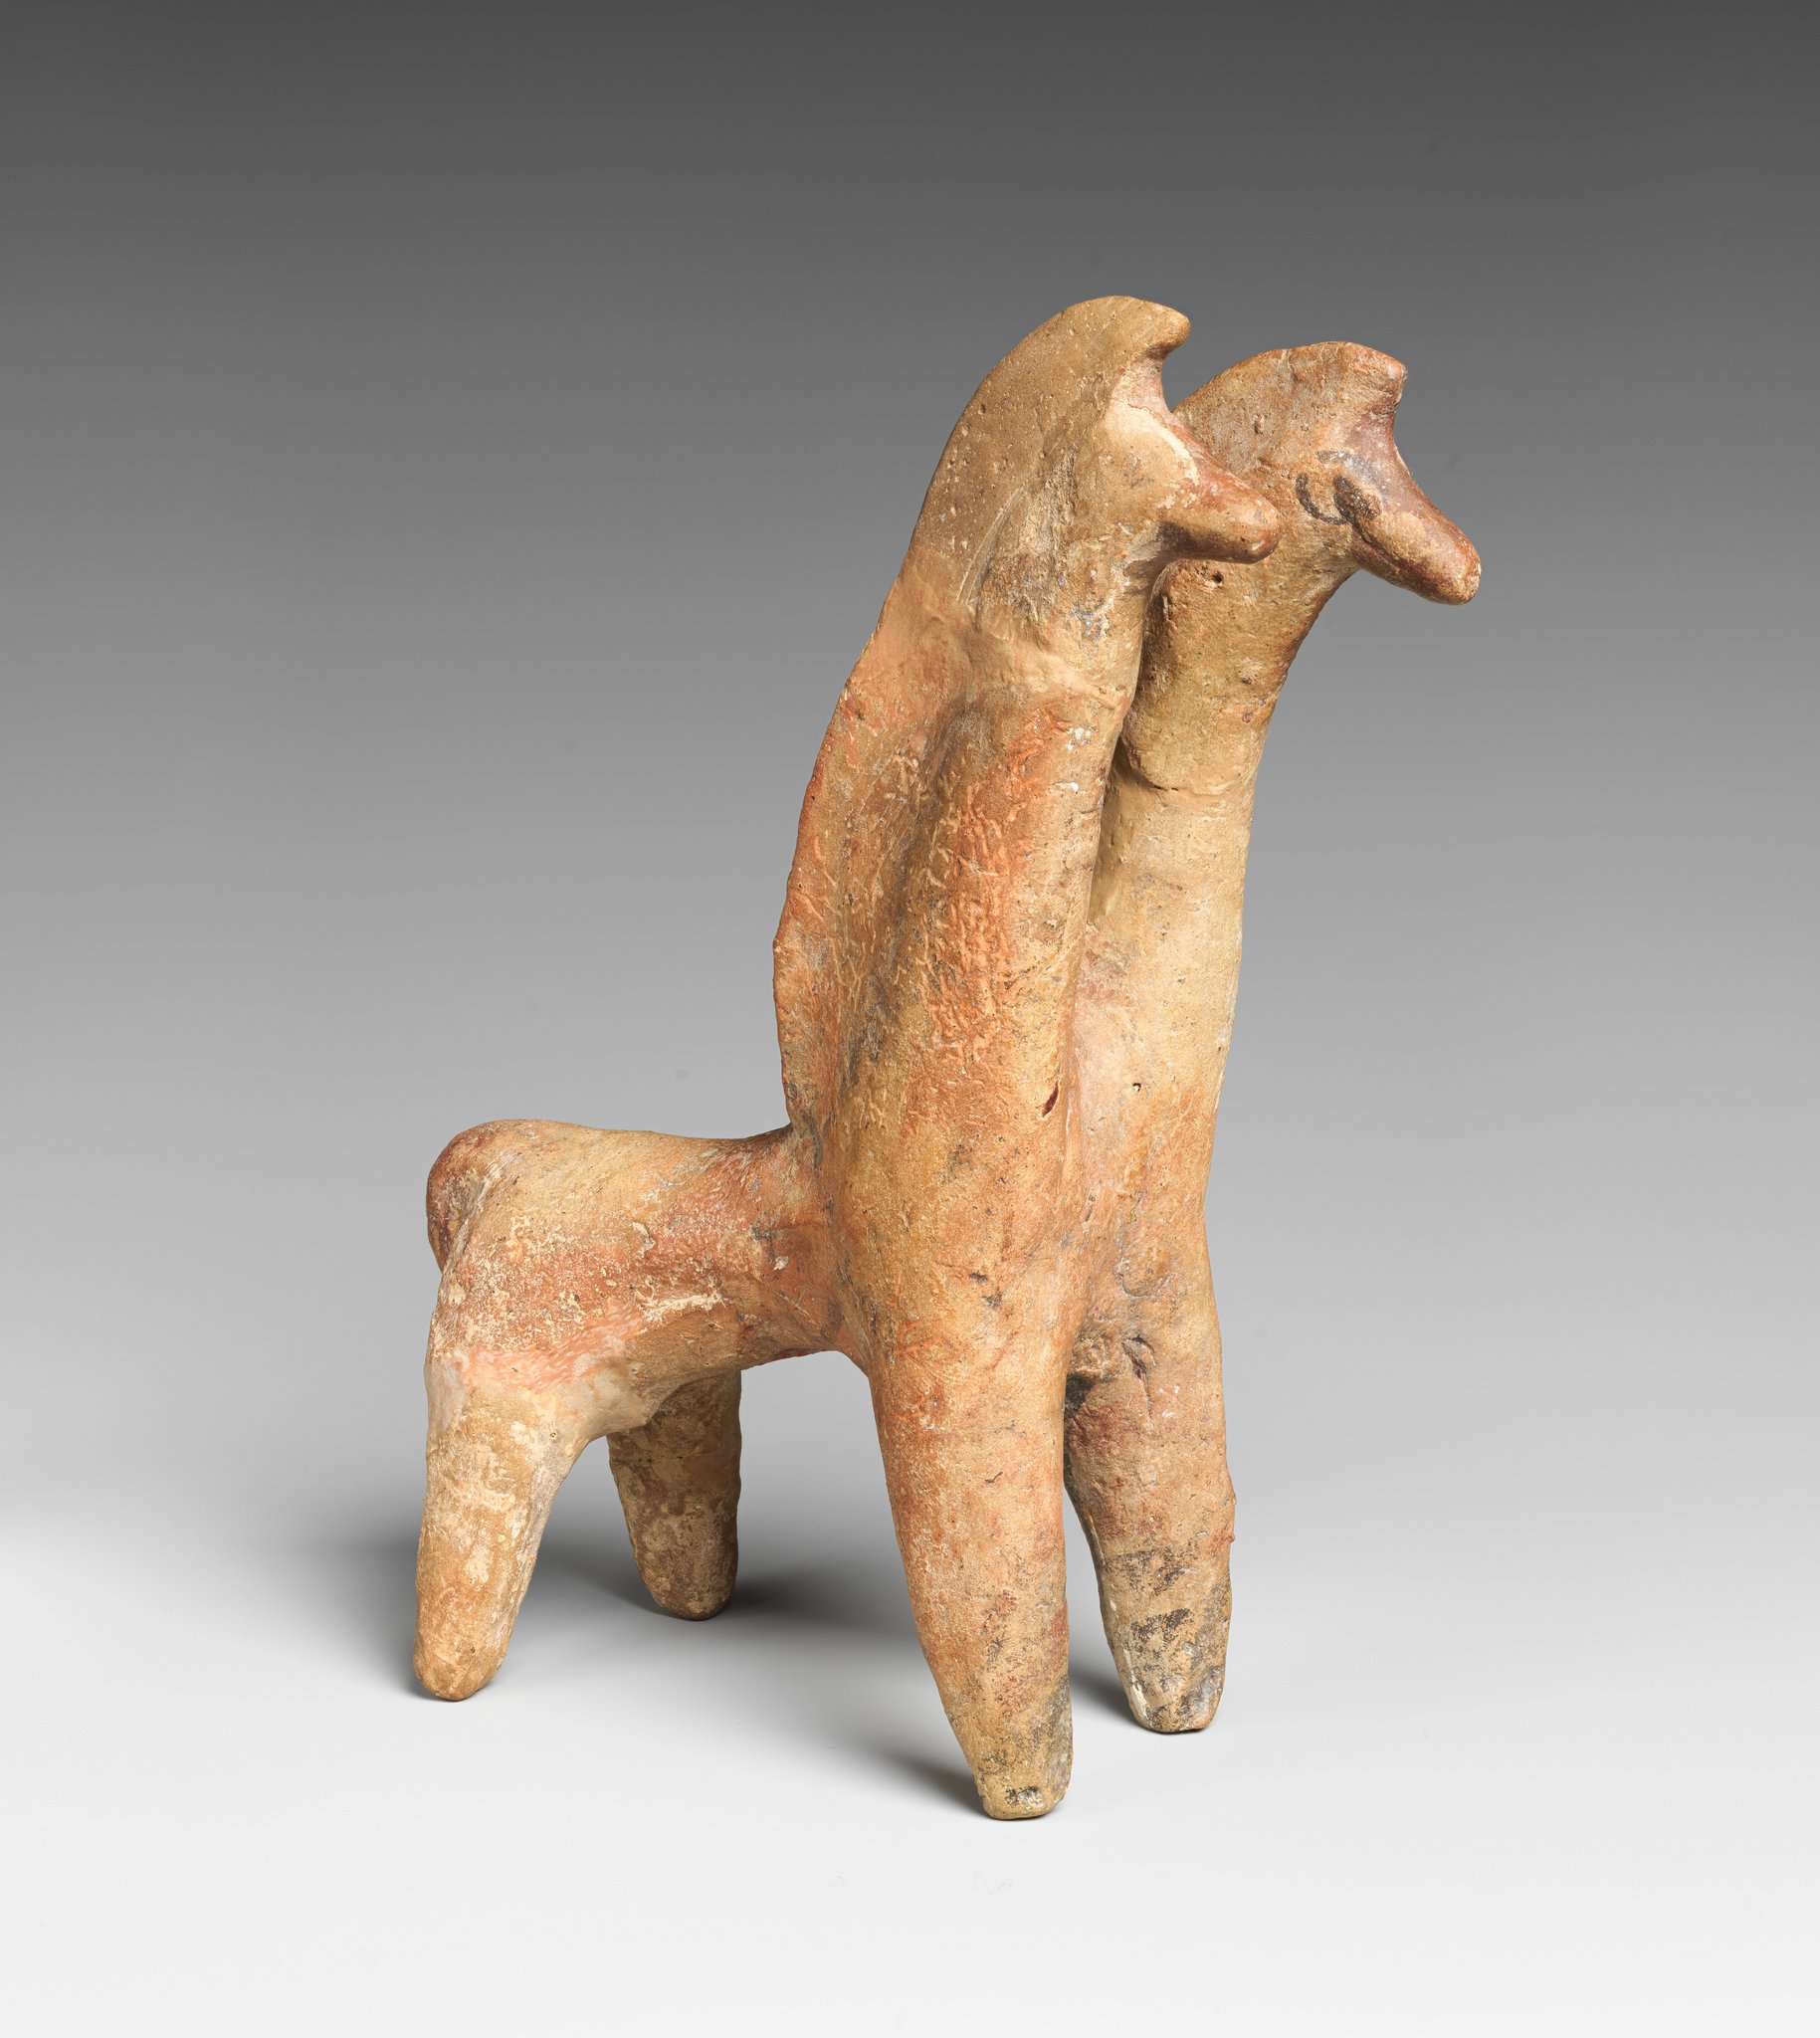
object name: figurine of a pair of horse with one body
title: Terracotta pair of horses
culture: cypriot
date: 750-600 BCE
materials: terracotta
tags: horses